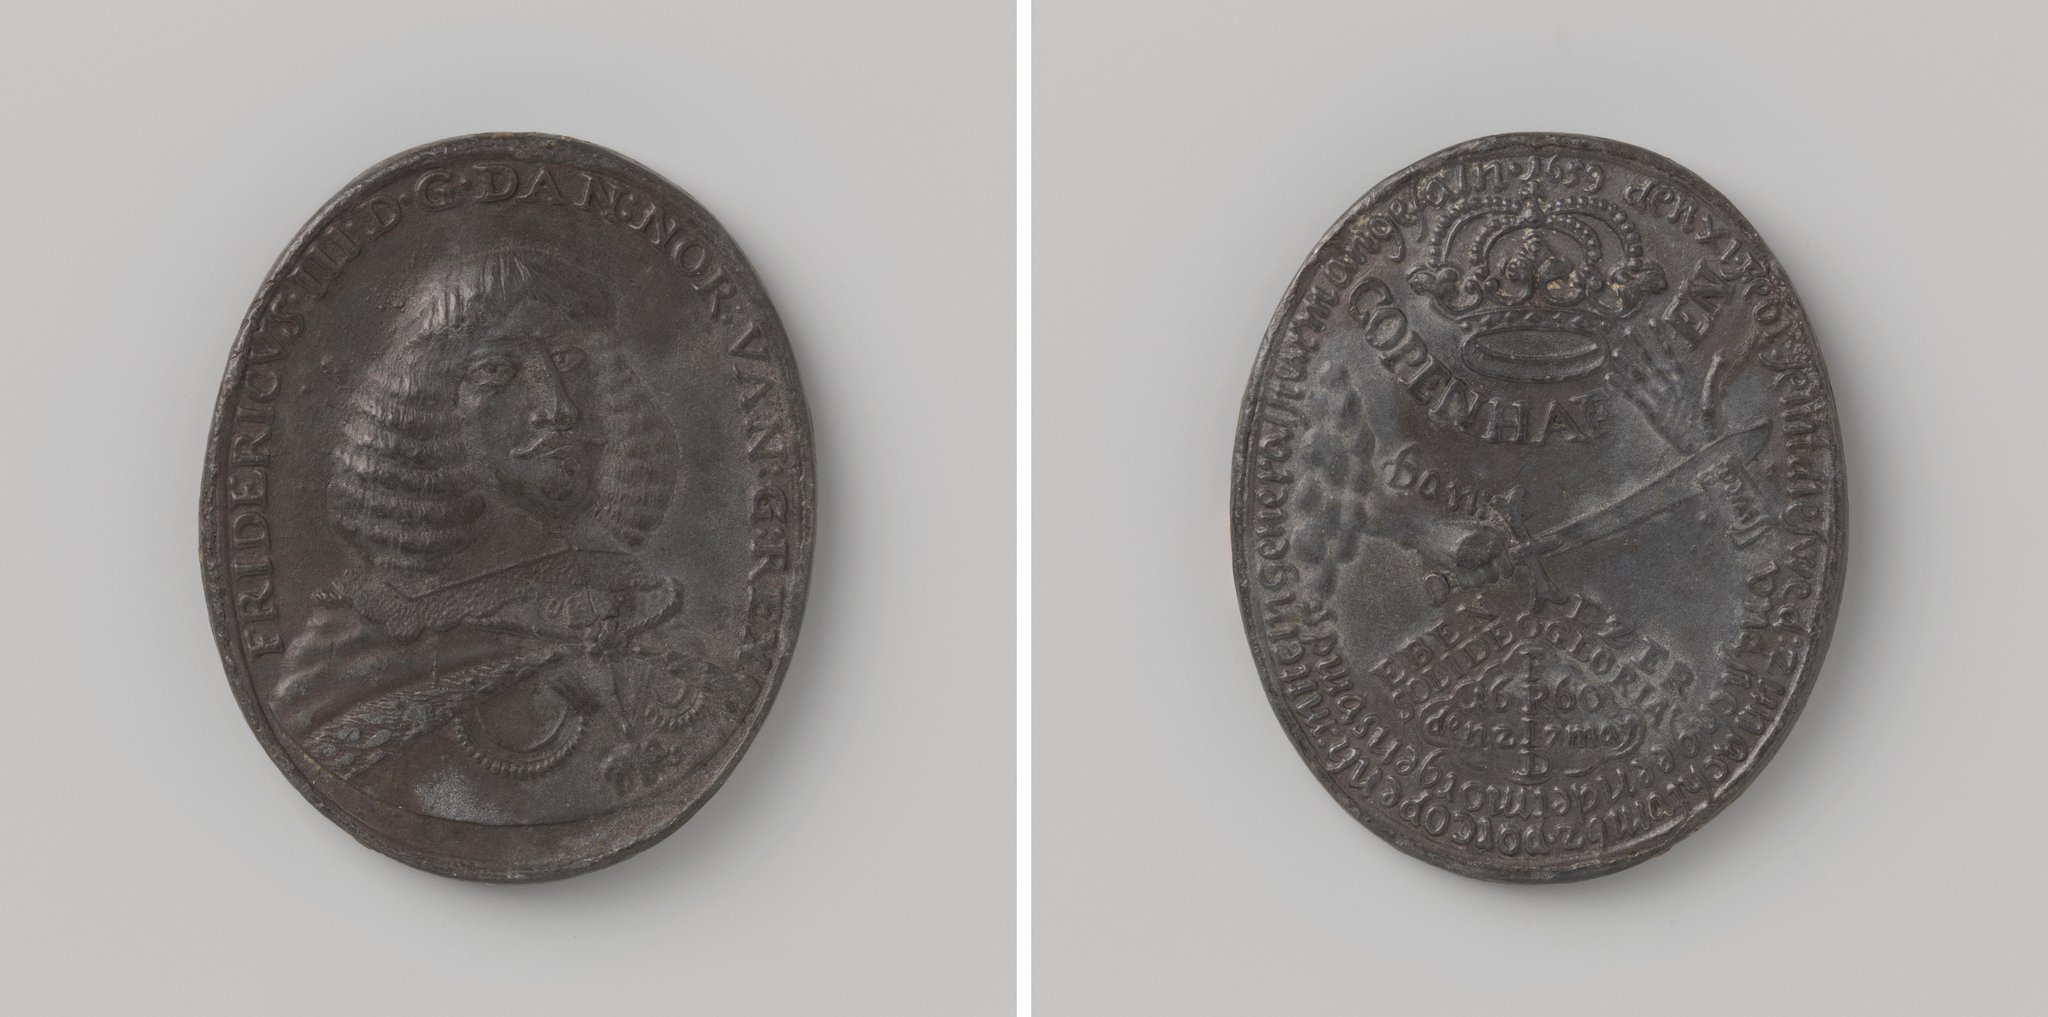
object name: copy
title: Aanslag van de Zweden op Kopenhagen en vrede van Kopenhagen tussen Denemarken en Zweden, ter ere van Frederik III, koning van Denemarken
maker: Anonymous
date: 1660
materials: silver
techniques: striking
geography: denmark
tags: frederik iii (koning van denemarken en noorwegen), copenhagen (city)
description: Zilveren ovale penning. Voorzijde: borststuk man binnen omschrift. Keerzijde: hand uit wolken met opschrift DAN hakt hand met opschrift SWED in tweeen, die naar kroon grijpt boven opschrift, binnen omschrift.